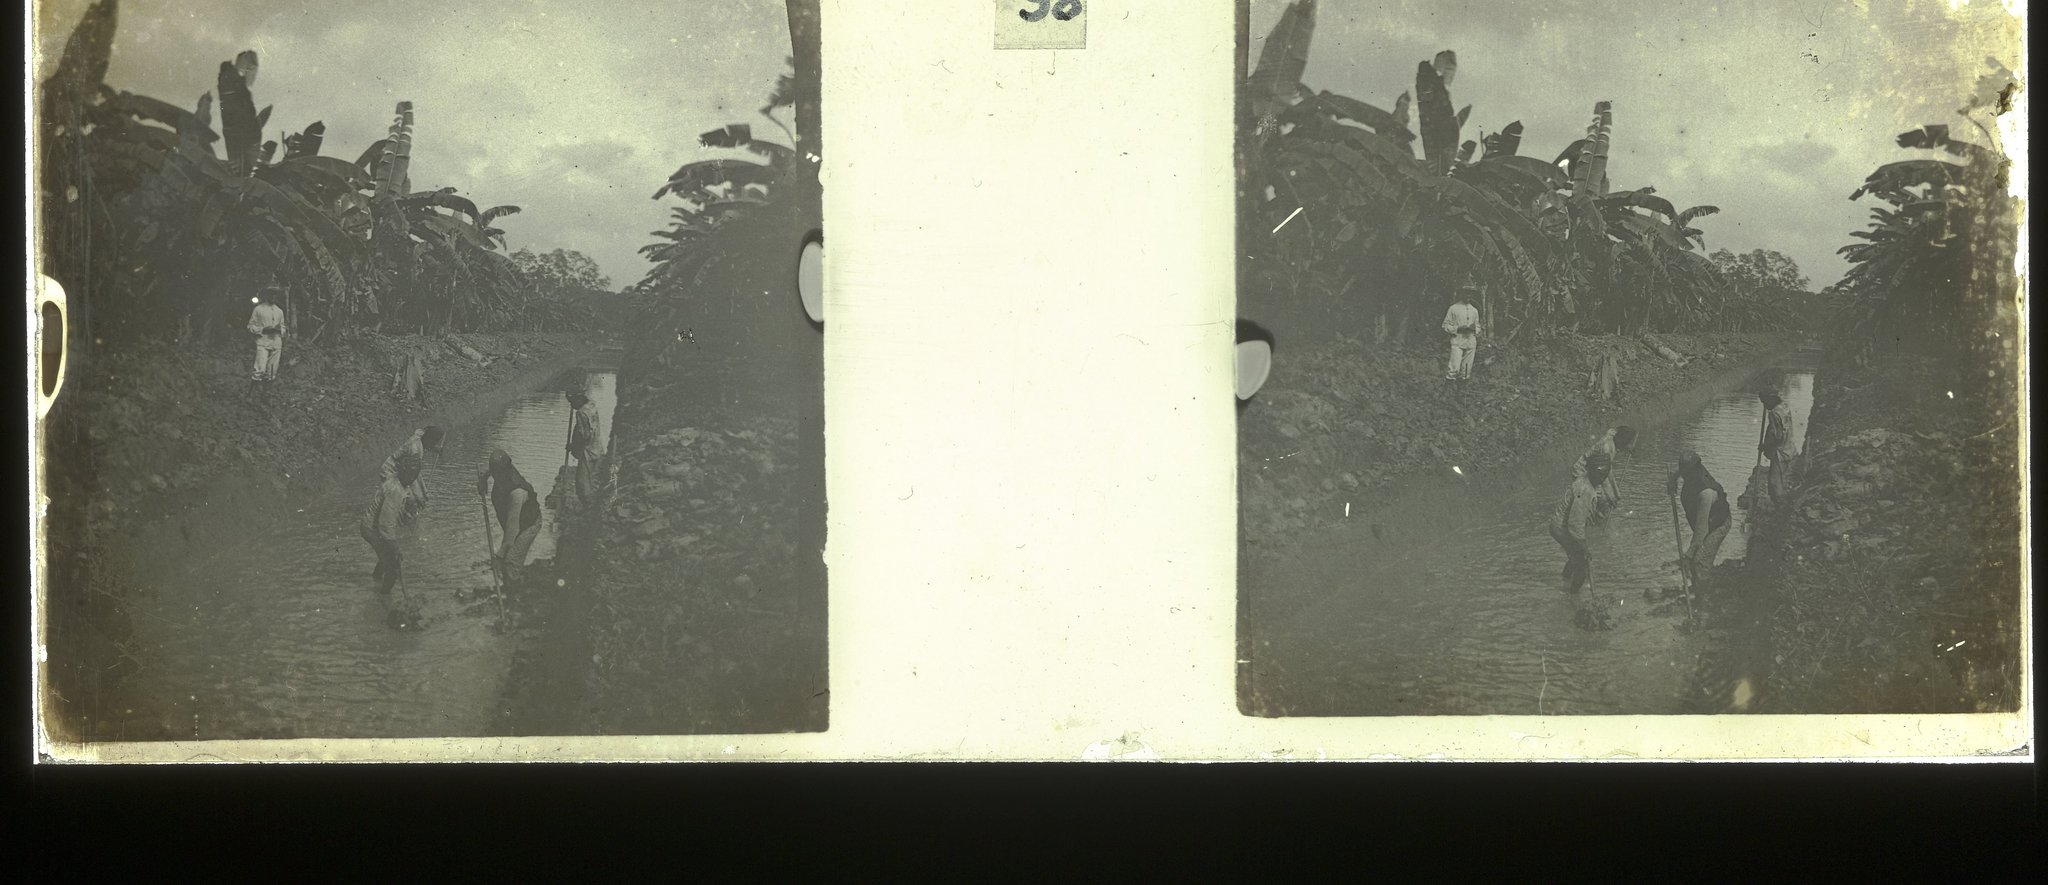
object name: stereograph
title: Arbeiders op plantage Accaribo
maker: theodoor brouwers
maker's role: amateurfotograaf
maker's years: 1874-1932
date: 1913-1930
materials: glass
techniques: photography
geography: suriname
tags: theodoor brouwers, plantation, suriname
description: In de periode 1911-1932 woonde op plantage Accaribo in Suriname de familie Brouwers van wie de foto's afkomstig zijn. Rond 1910 vond Theodoor Brouwers werk op plantage Accaribo. In 1929 werd hij eigenaar van de plantage. Op Accaribo werden in zijn tijd bananen geproduceerd en wat koffie.